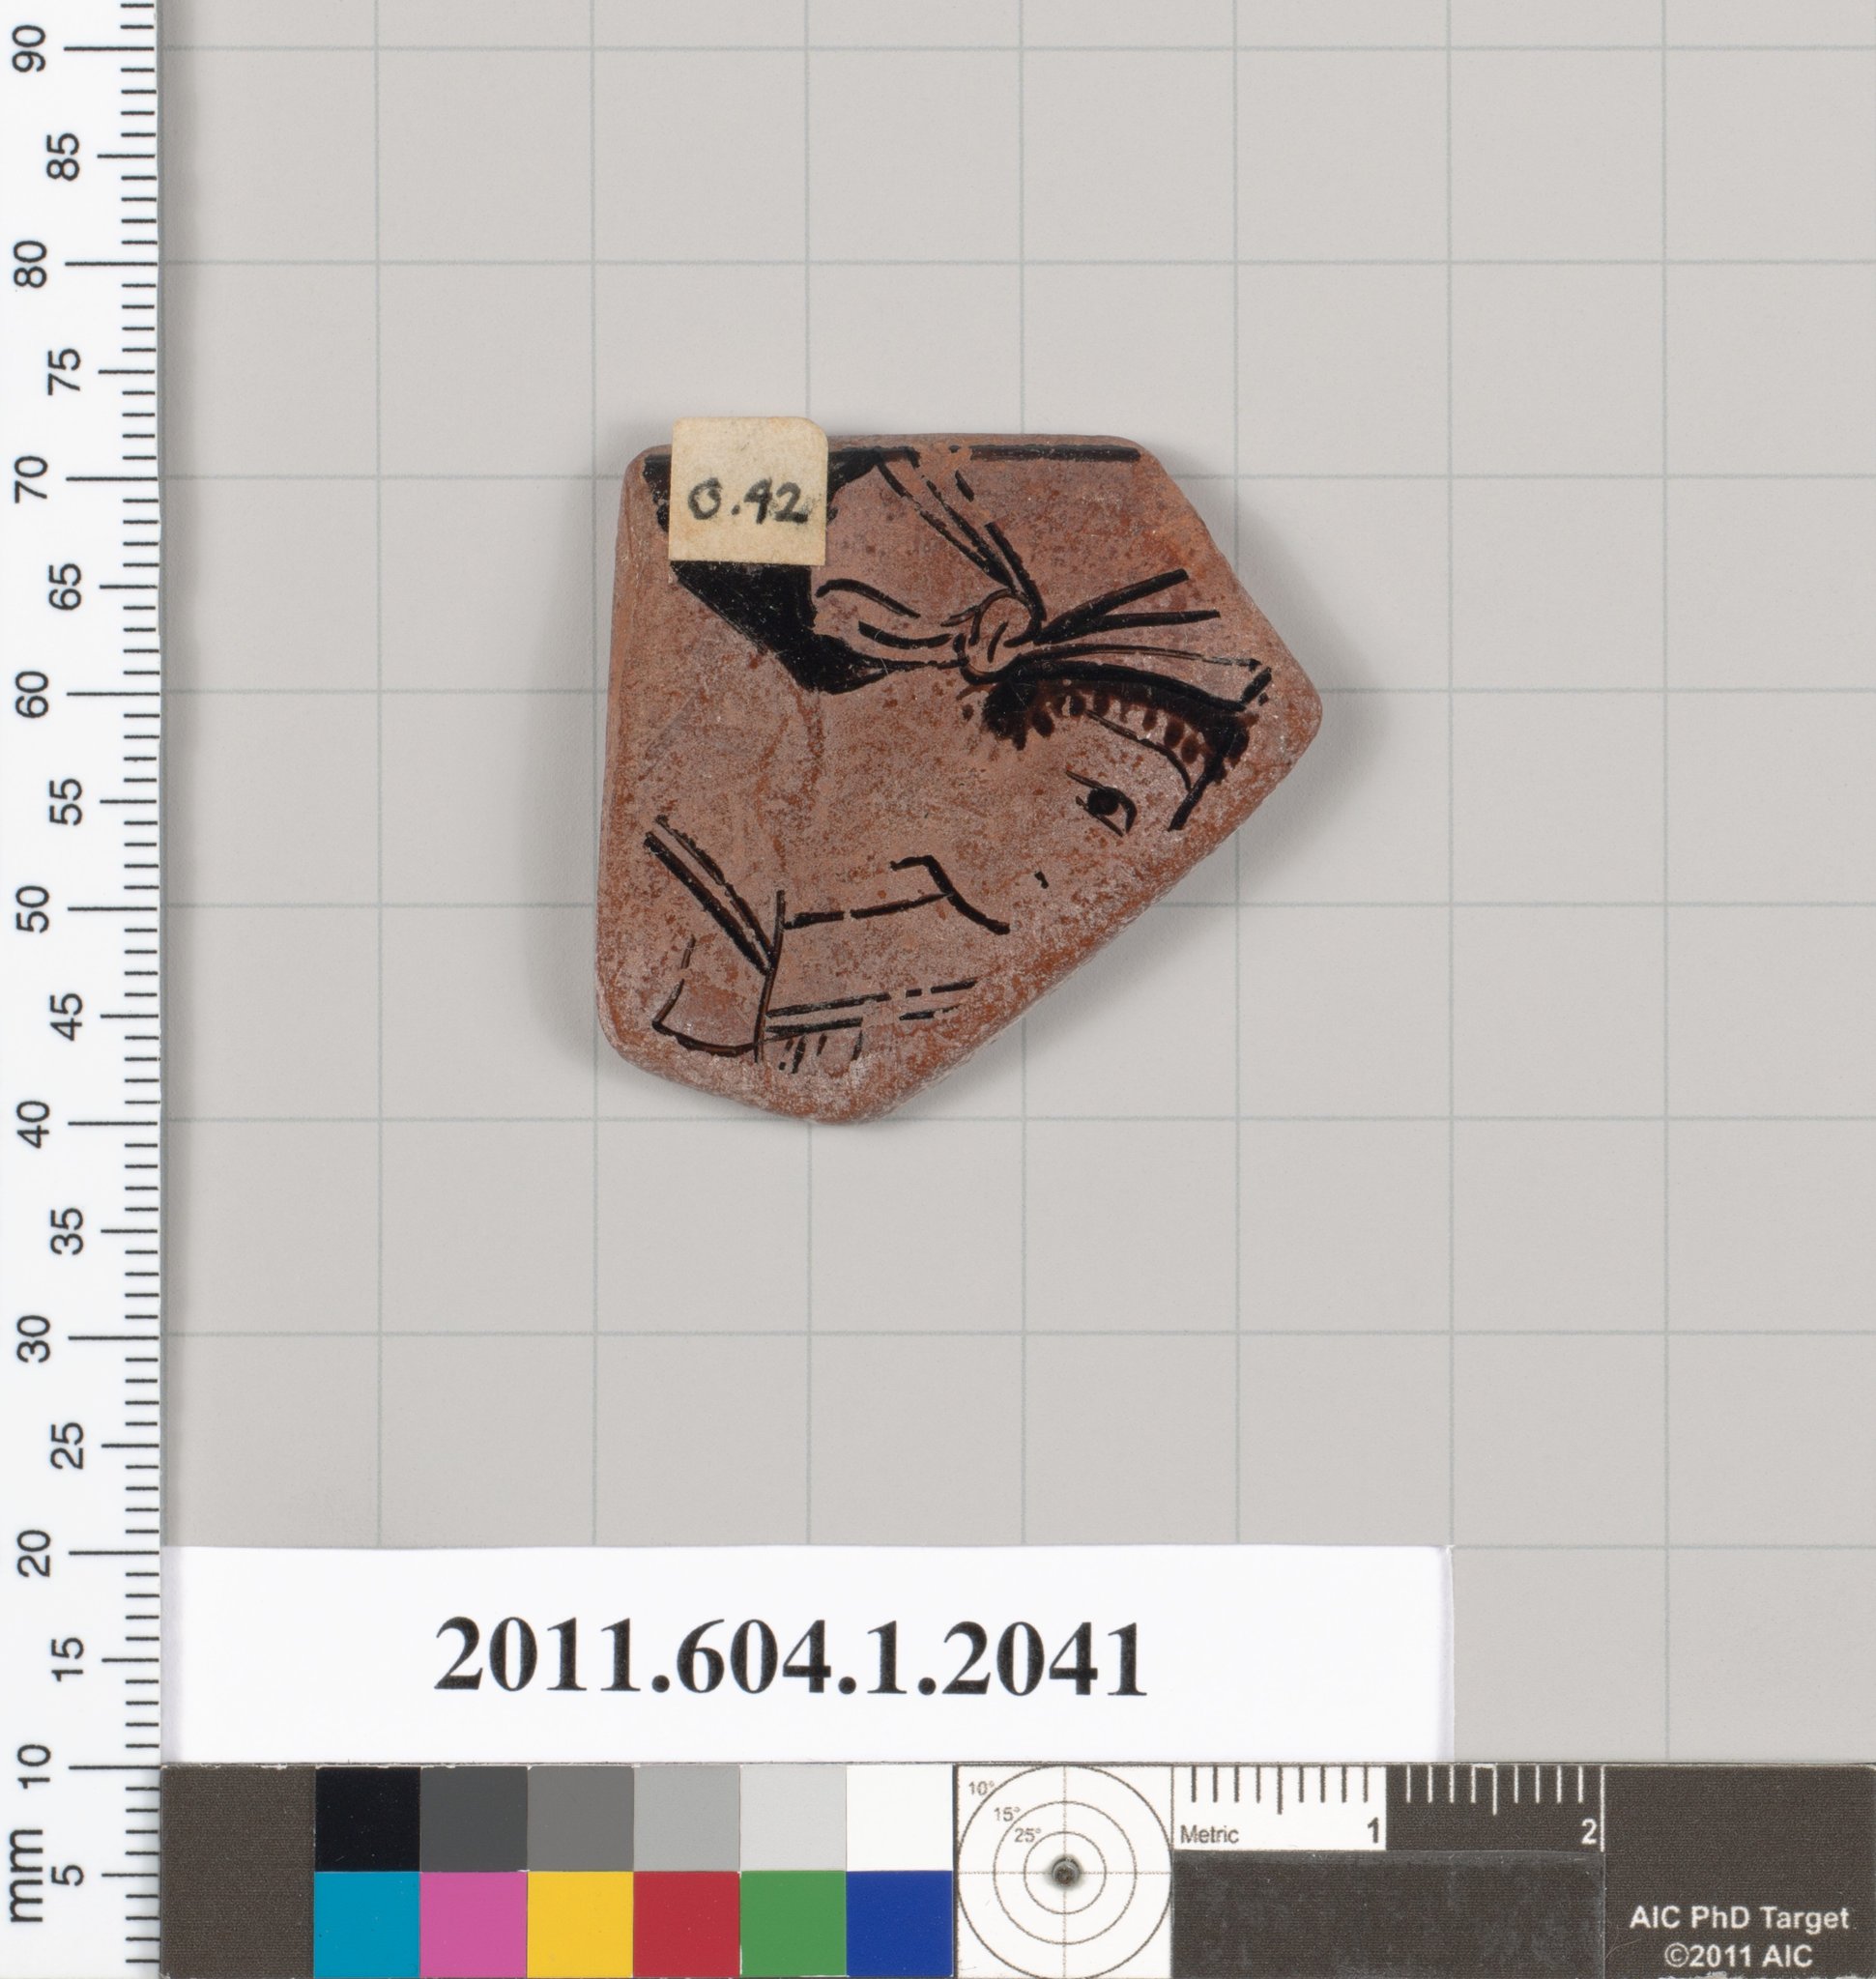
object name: kylix fragment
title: Terracotta rim fragment of a kylix (drinking cup)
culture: greek, attic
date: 534-501 BCE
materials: terracotta